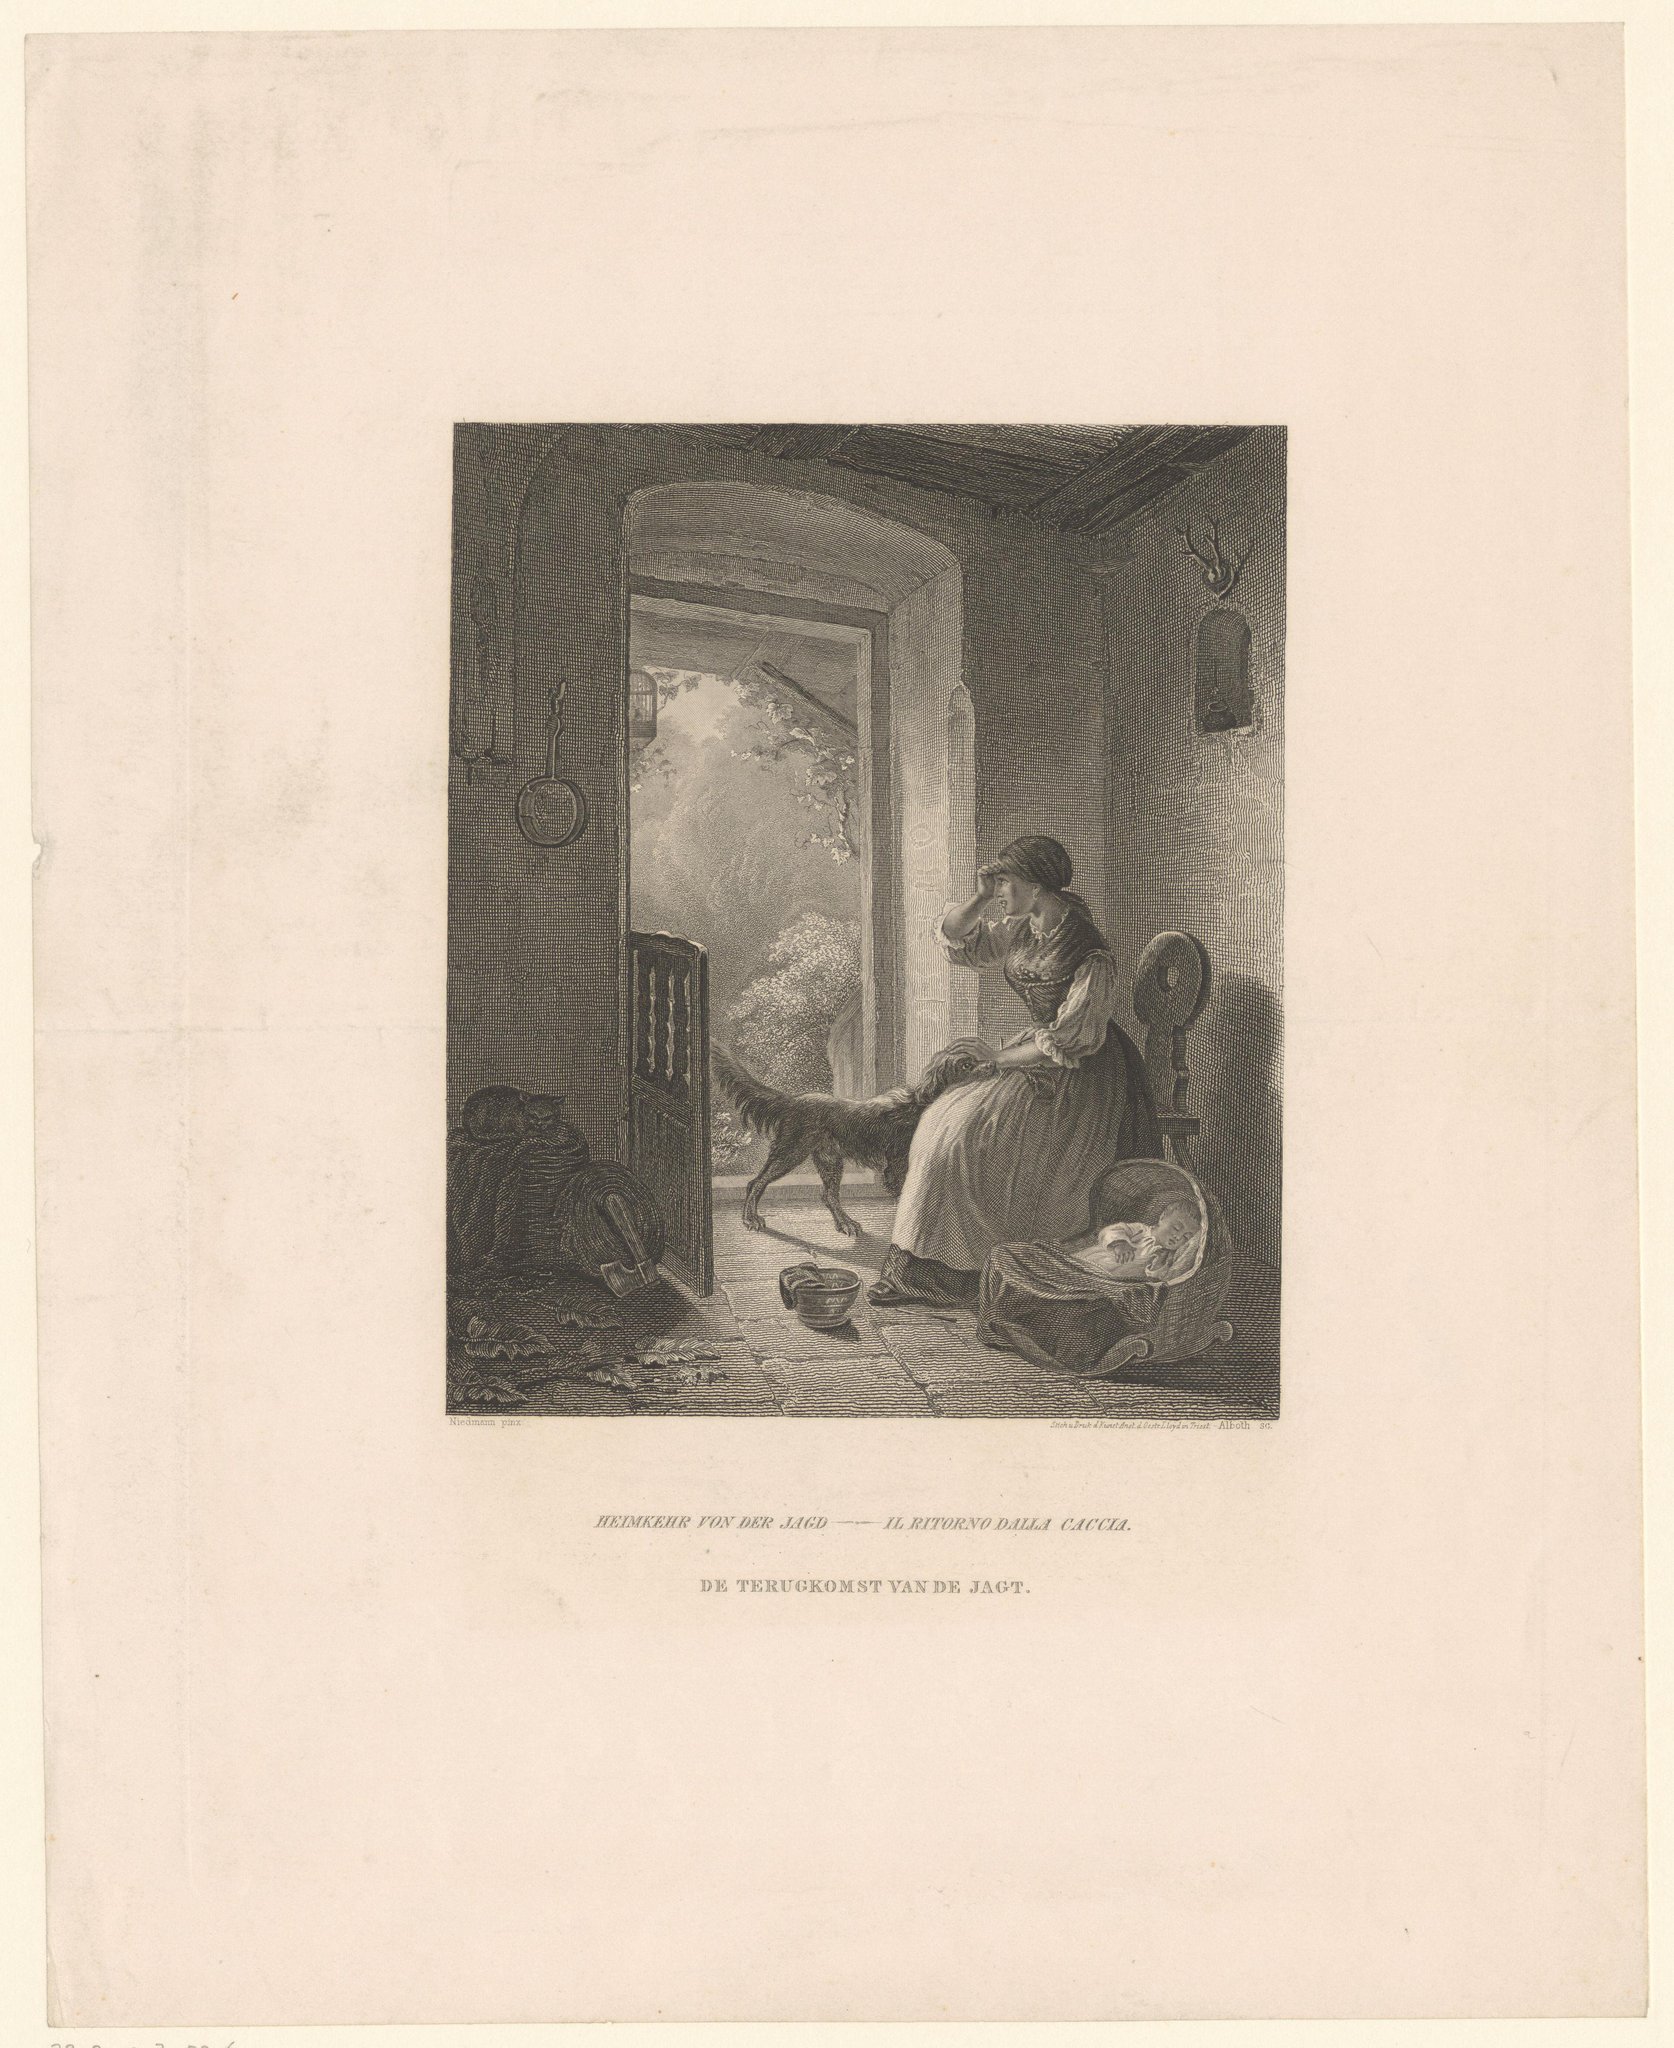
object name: print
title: De terugkomst van de jagt / Heimkehr von der Jagd / Il ritorno dalla caccia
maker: august heinrich niedmann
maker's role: painter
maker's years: 1826-1910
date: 1850-1900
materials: paper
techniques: etching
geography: trieste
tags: hunting dogs, cradle, crib, return from the hunt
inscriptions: collector's mark: Lugt 2228